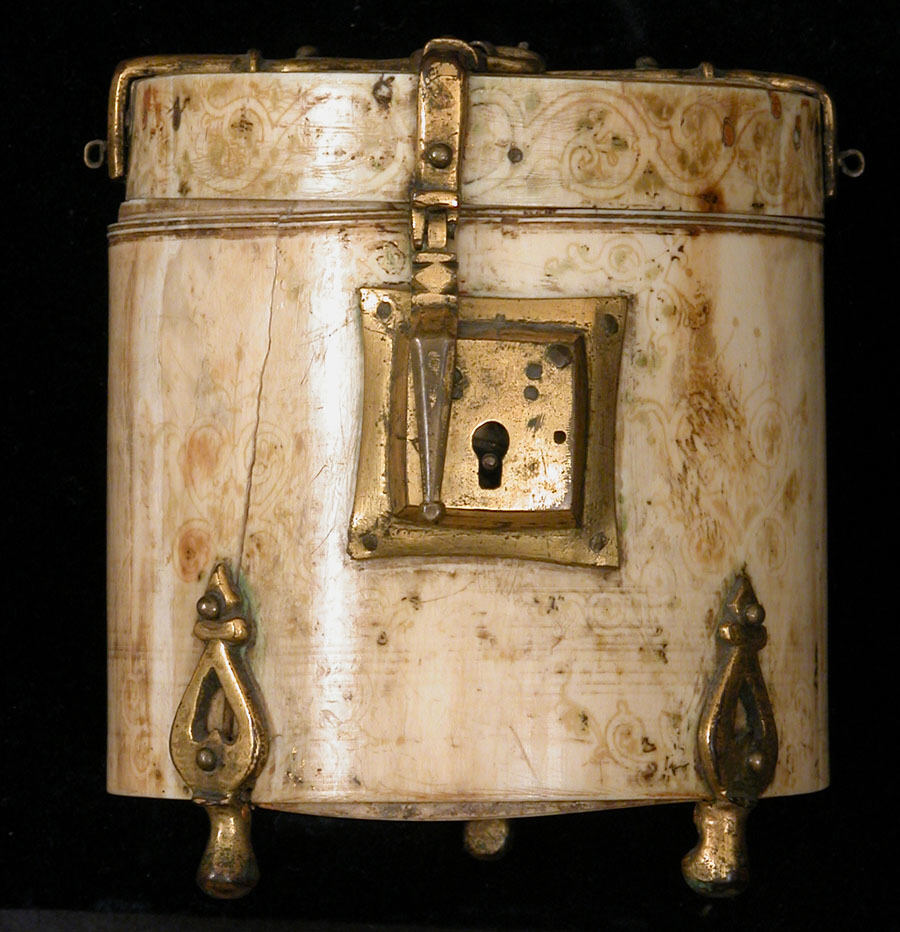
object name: box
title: Pyxis with Painted Designs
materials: alloy, gilt copper, ivory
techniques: painting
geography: italy